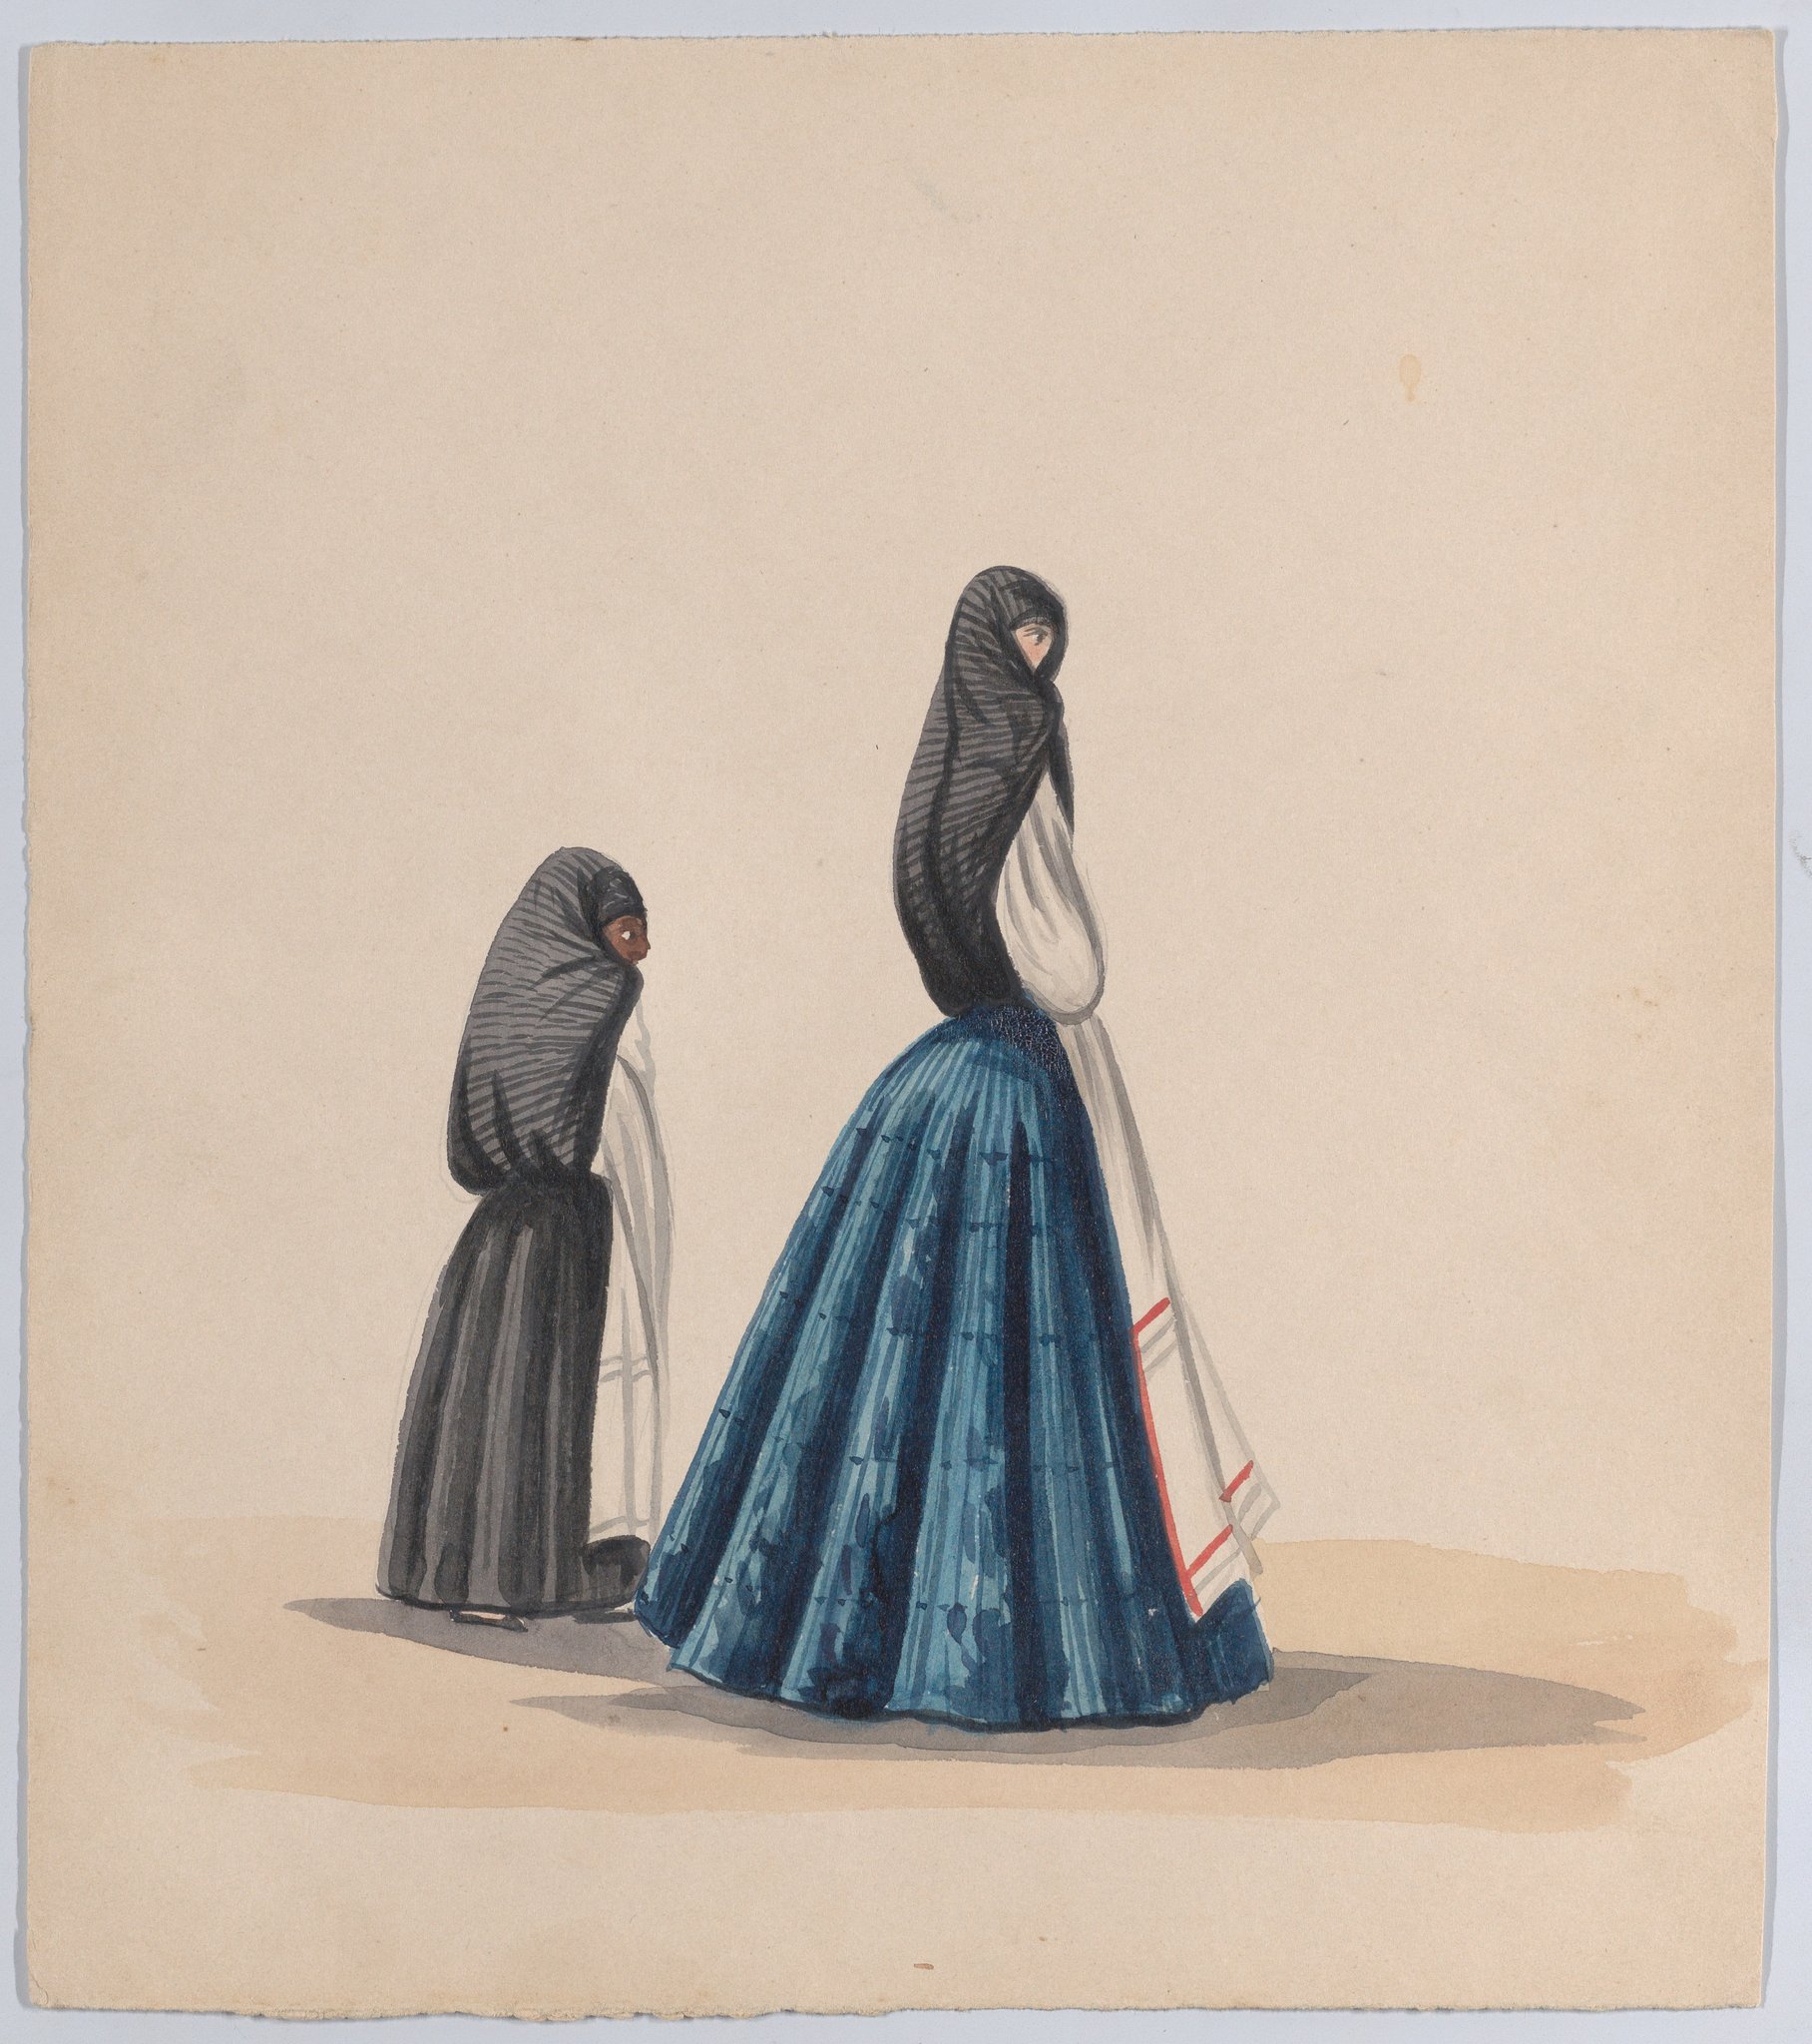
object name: drawing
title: Two woman wearing the saya viewed in profile, from a group of drawings depicting Peruvian dress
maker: francisco (pancho) fierro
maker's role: artist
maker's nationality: african peruvian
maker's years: 1807-1879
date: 1848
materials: watercolor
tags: women